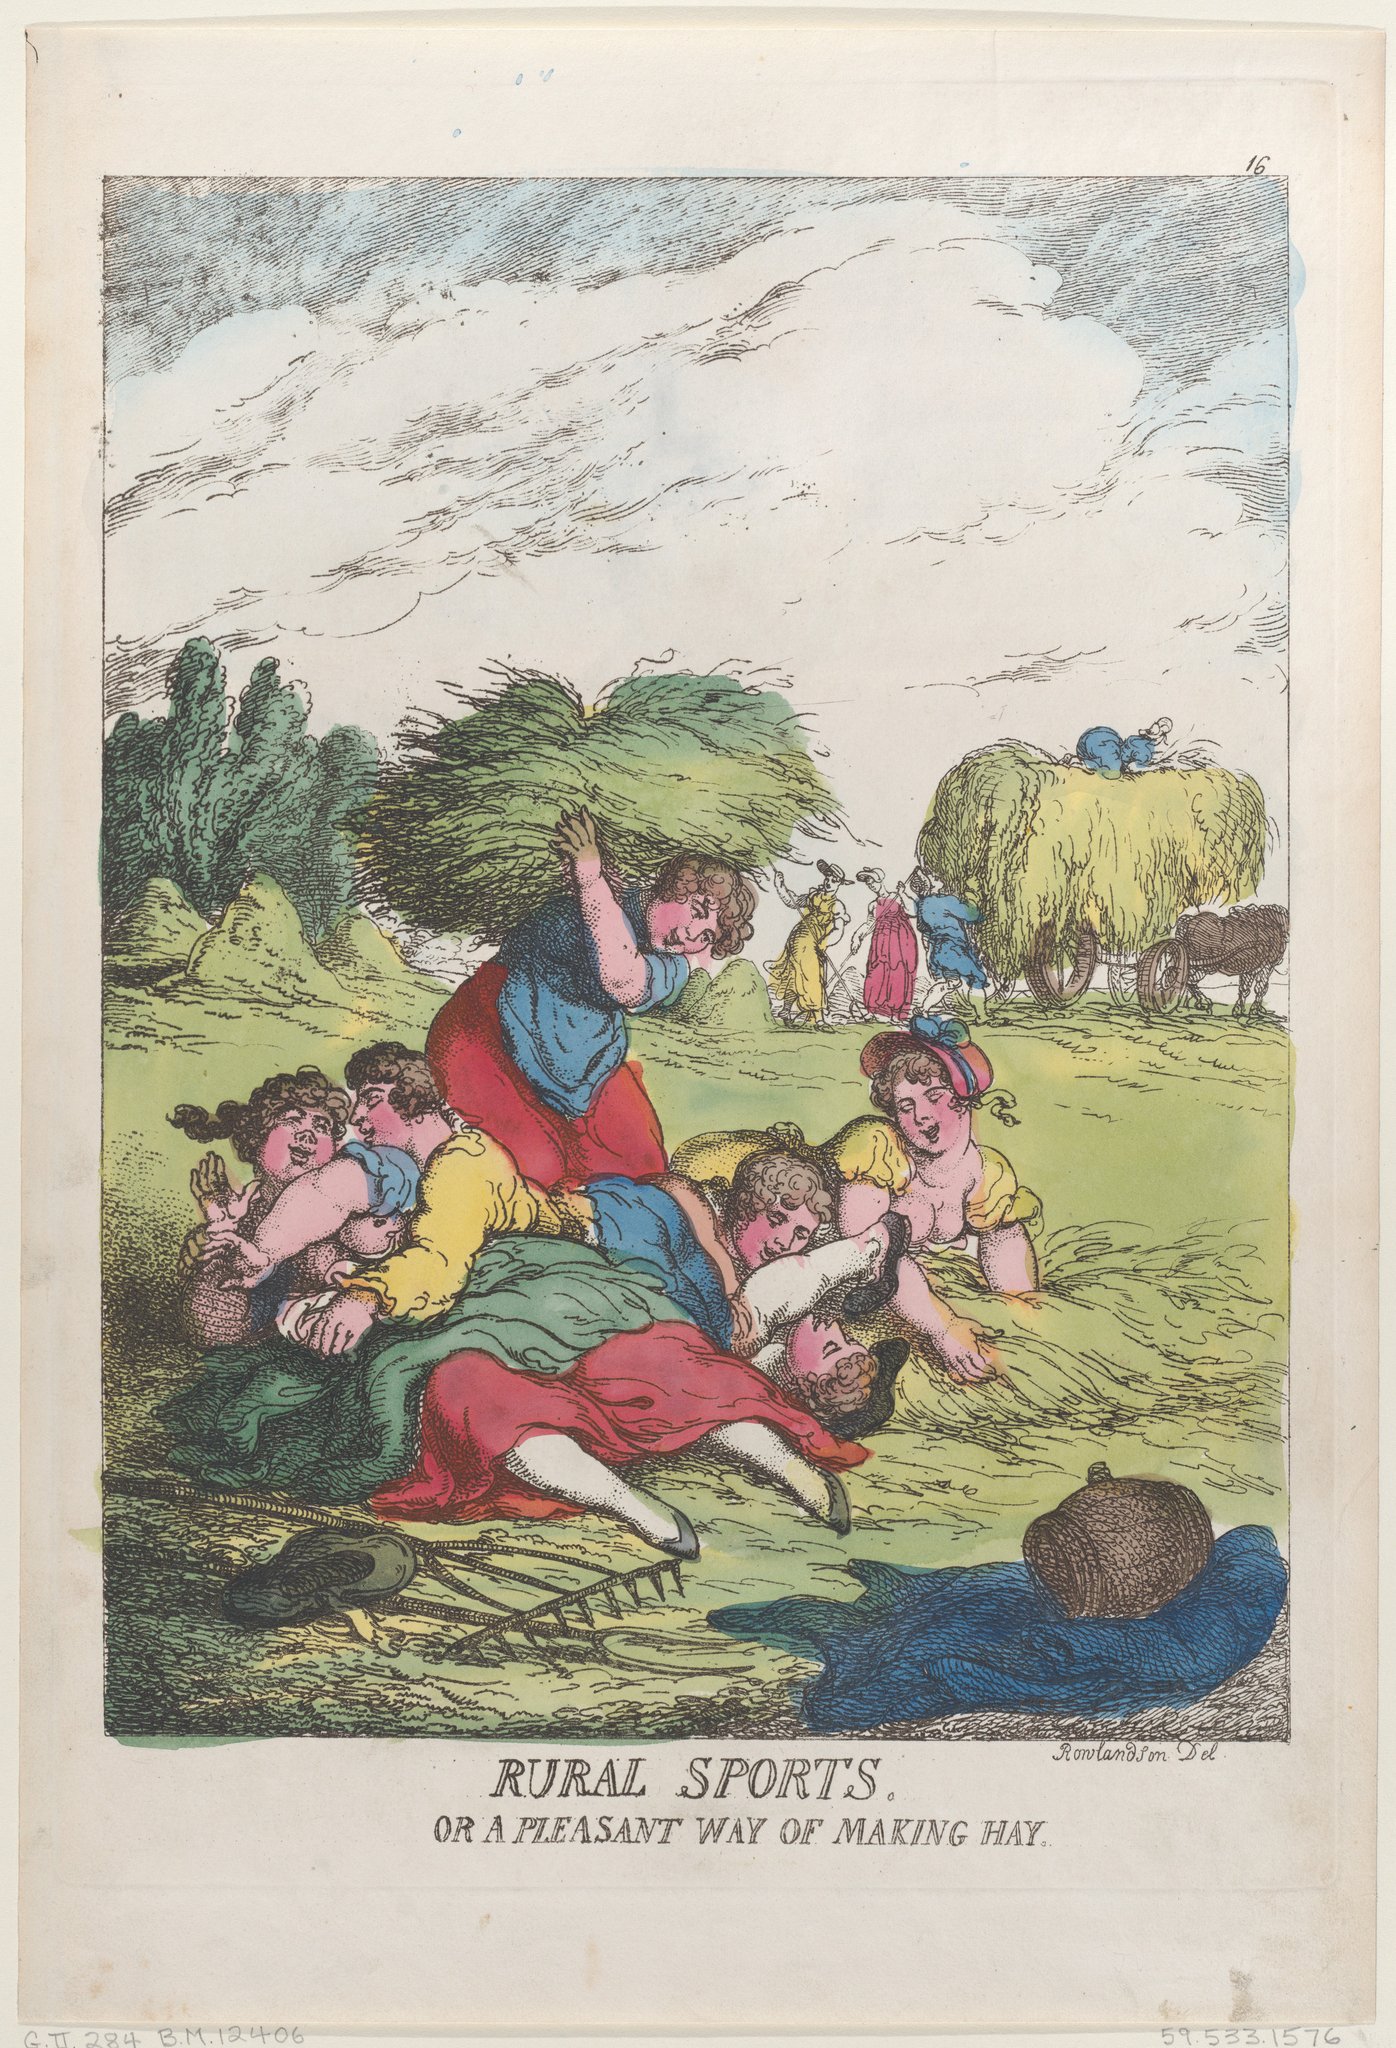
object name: print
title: Rural Sports, or a Pleasant Way of Making Hay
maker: thomas rowlandson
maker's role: artist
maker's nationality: british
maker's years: 1757-1827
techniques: etching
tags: satire,men,women